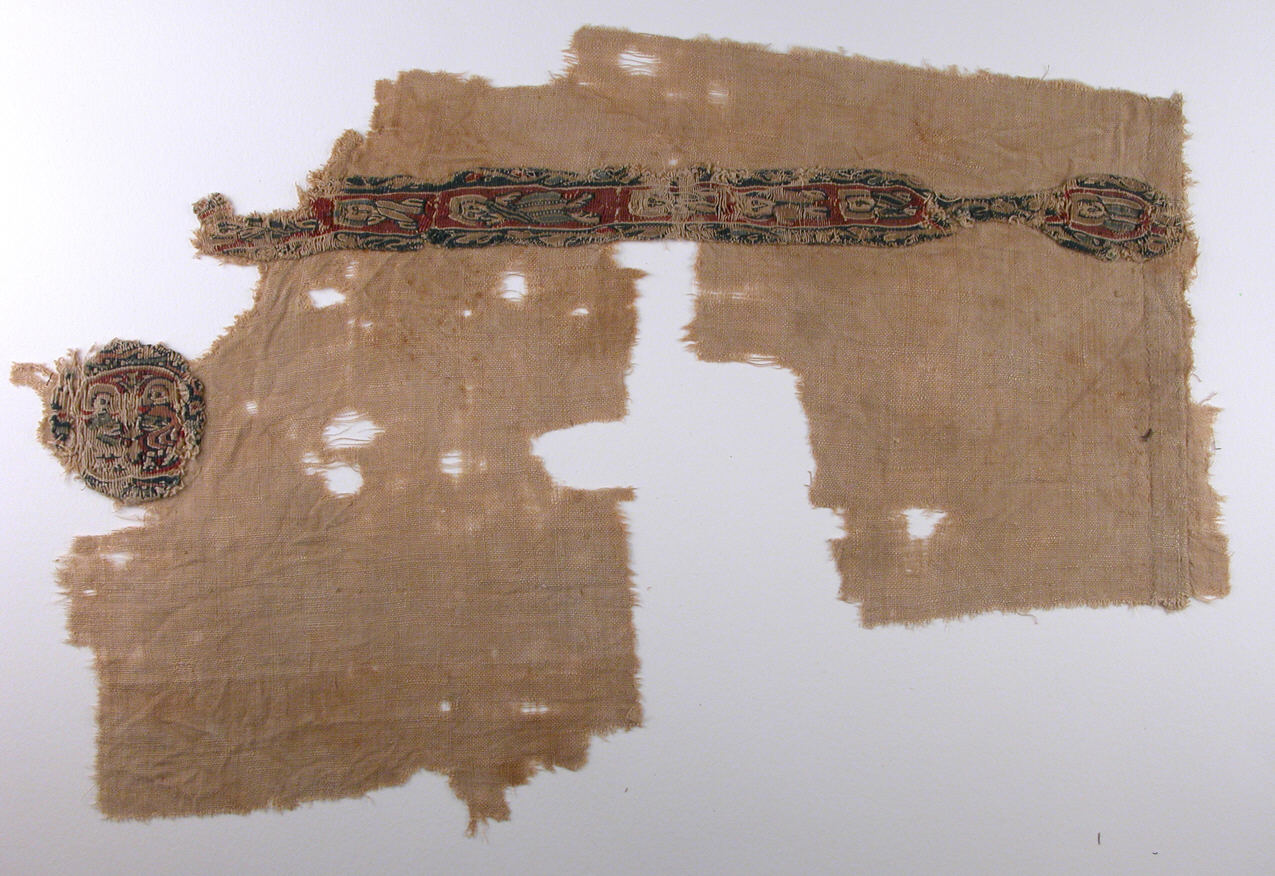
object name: textile fragment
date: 501-700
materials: linen, wool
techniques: weave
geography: egypt